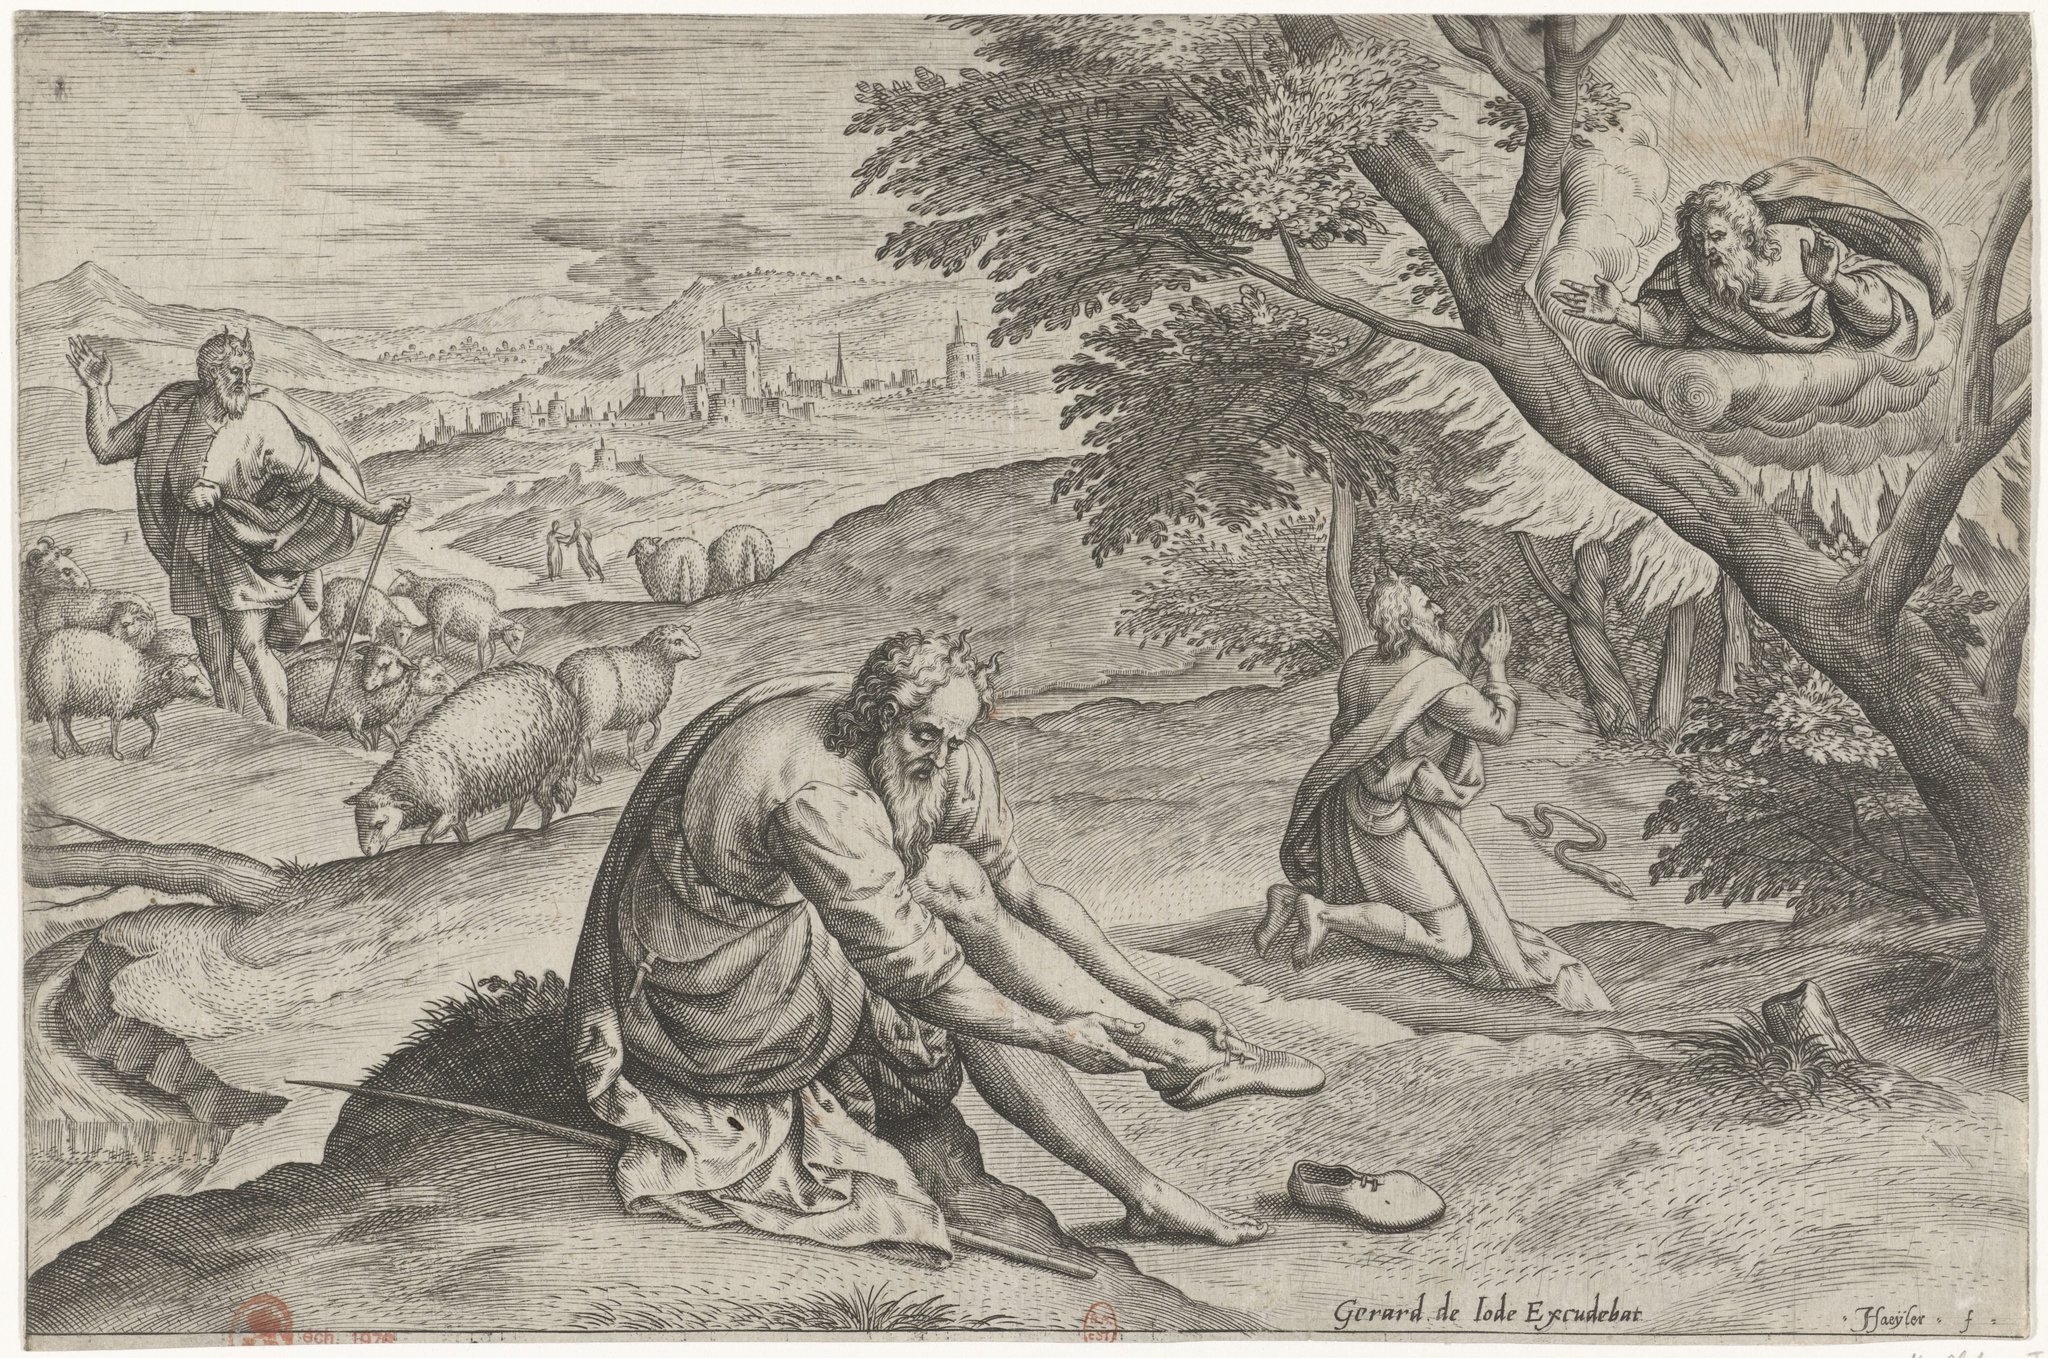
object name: print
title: Historia plagarum in Aegijpto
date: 1579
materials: paper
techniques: engraving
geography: antwerp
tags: while tending jethro's flock moses comes to horeb, god the father as bearded old man, usually with crown or tiara or sceptre and/or globe, a burning bush attracts moses' attention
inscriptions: collector's mark: Lugt 2228, collector's mark: Lugt 400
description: Op de voorgrond trekt Mozes zijn schoenen uit. Op het tweede plan rechts knielt Mozes voor het brandende braambos waarboven God verschijnt. Op de achtergrond links hoedt Mozes schapen. De eerste prent van een achtdelige serie over de geschiedenis van Mozes voor de vlucht uit Egypte.